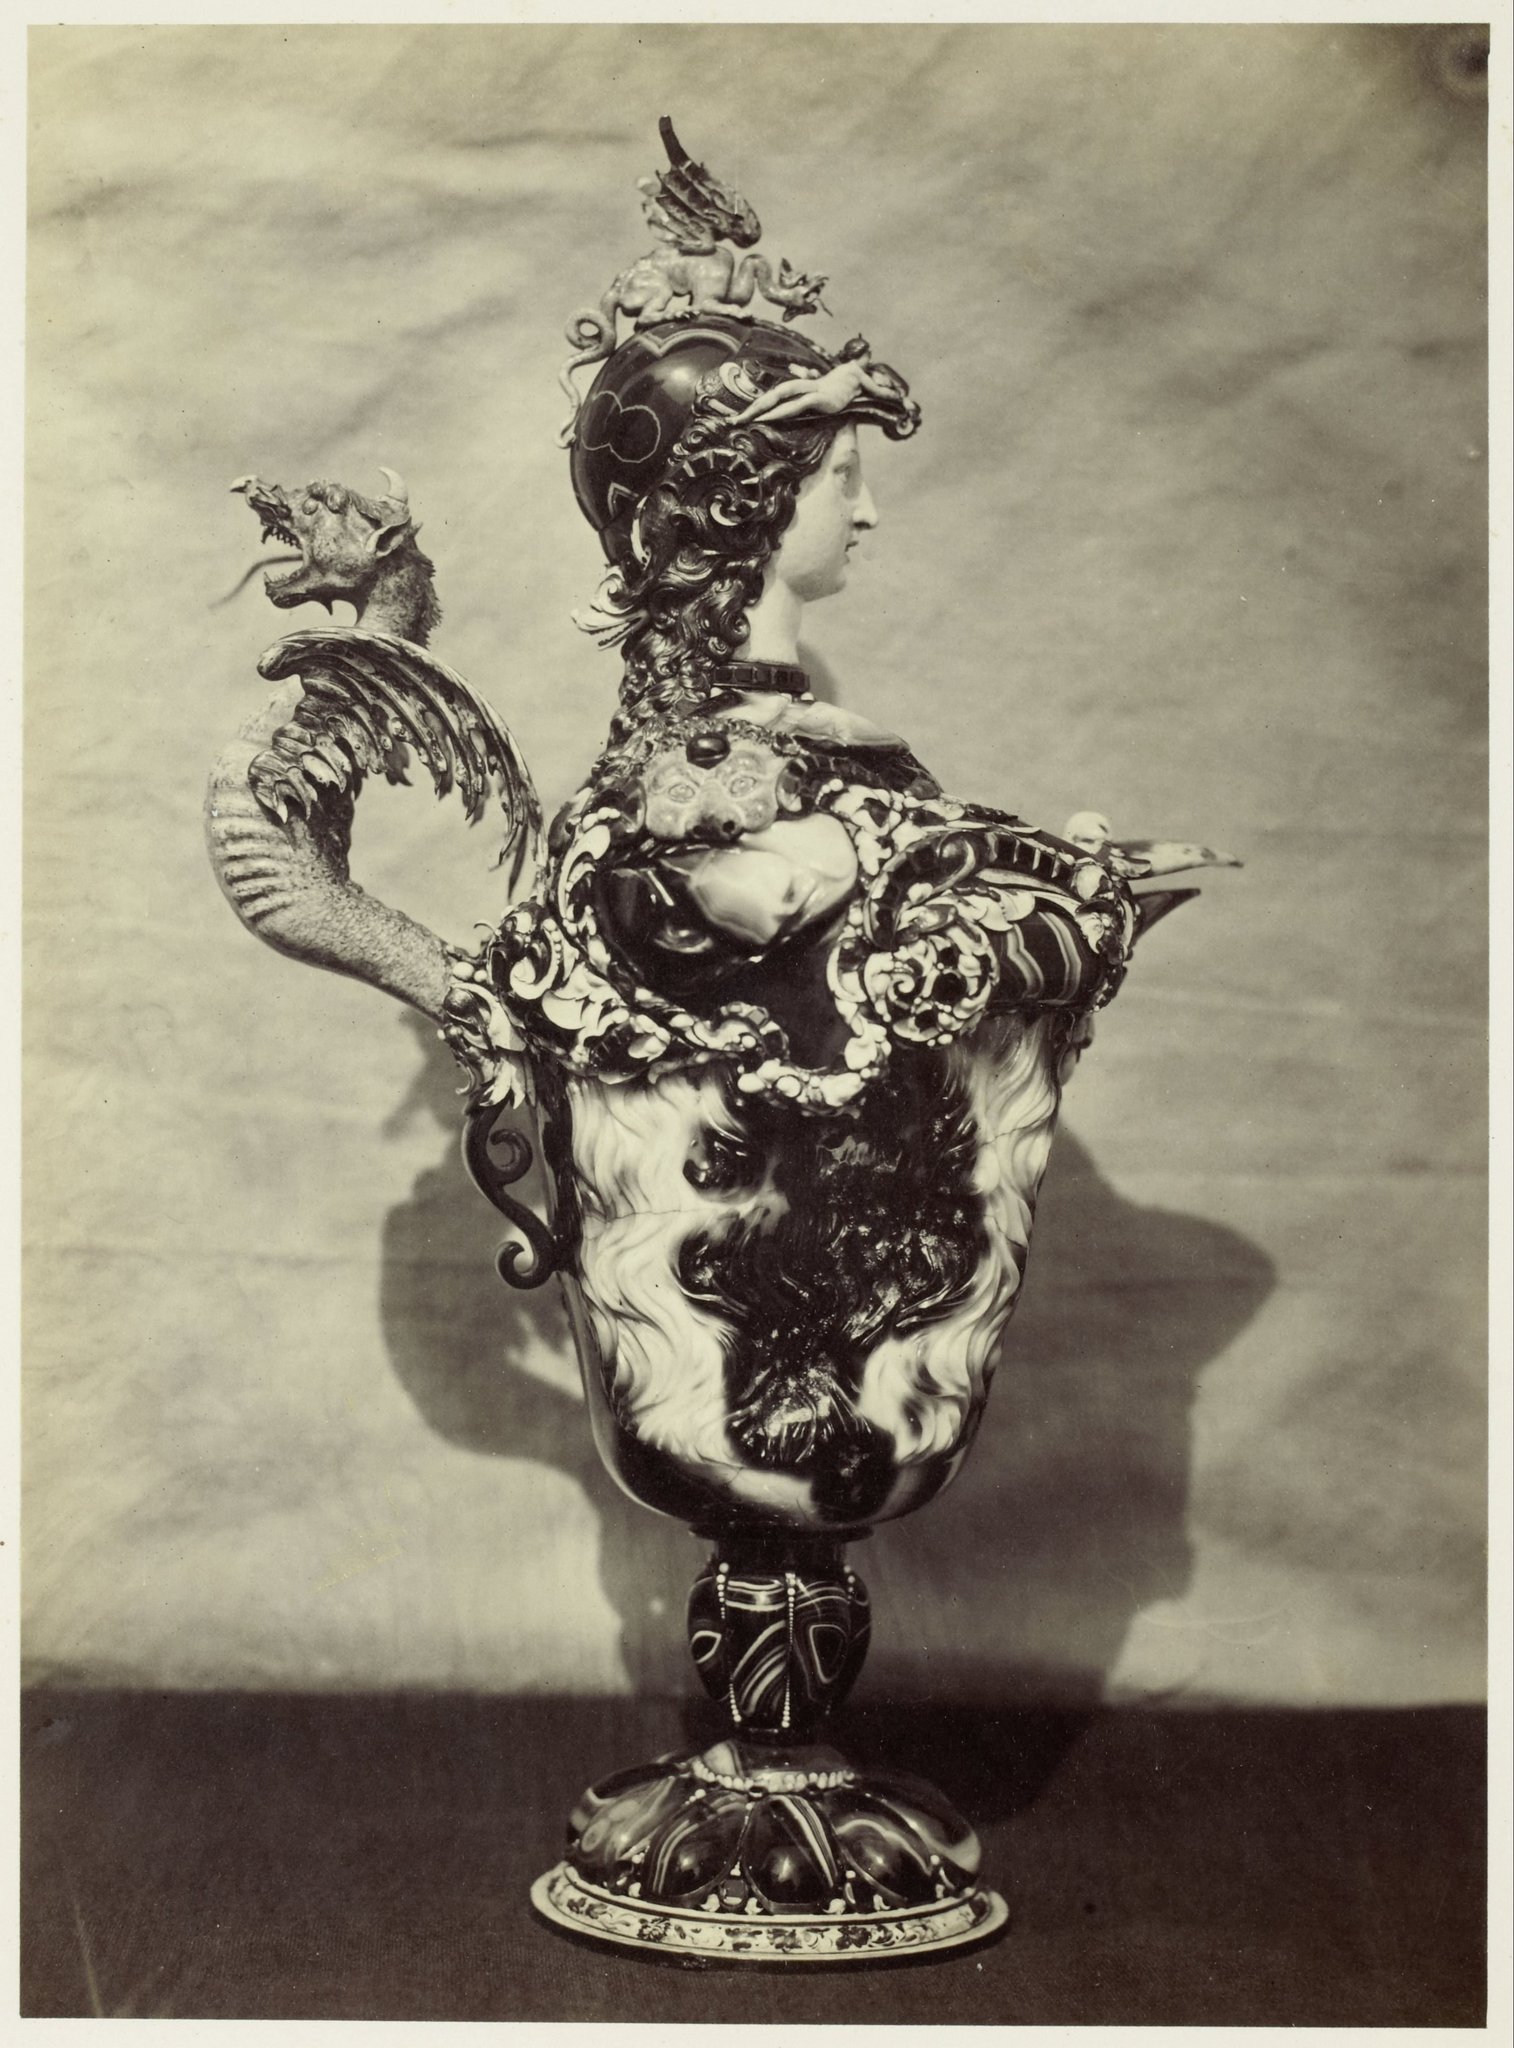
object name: photomechanical print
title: Kan met decoratie in de vorm van een vrouw en draken, uit het Louvre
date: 1866-1890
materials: paper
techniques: woodburytype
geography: louvre museum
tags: container of ceramics: jar, jug, pot, vase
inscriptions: inscription: ‘Photographed by C. Thurston Thompson.’